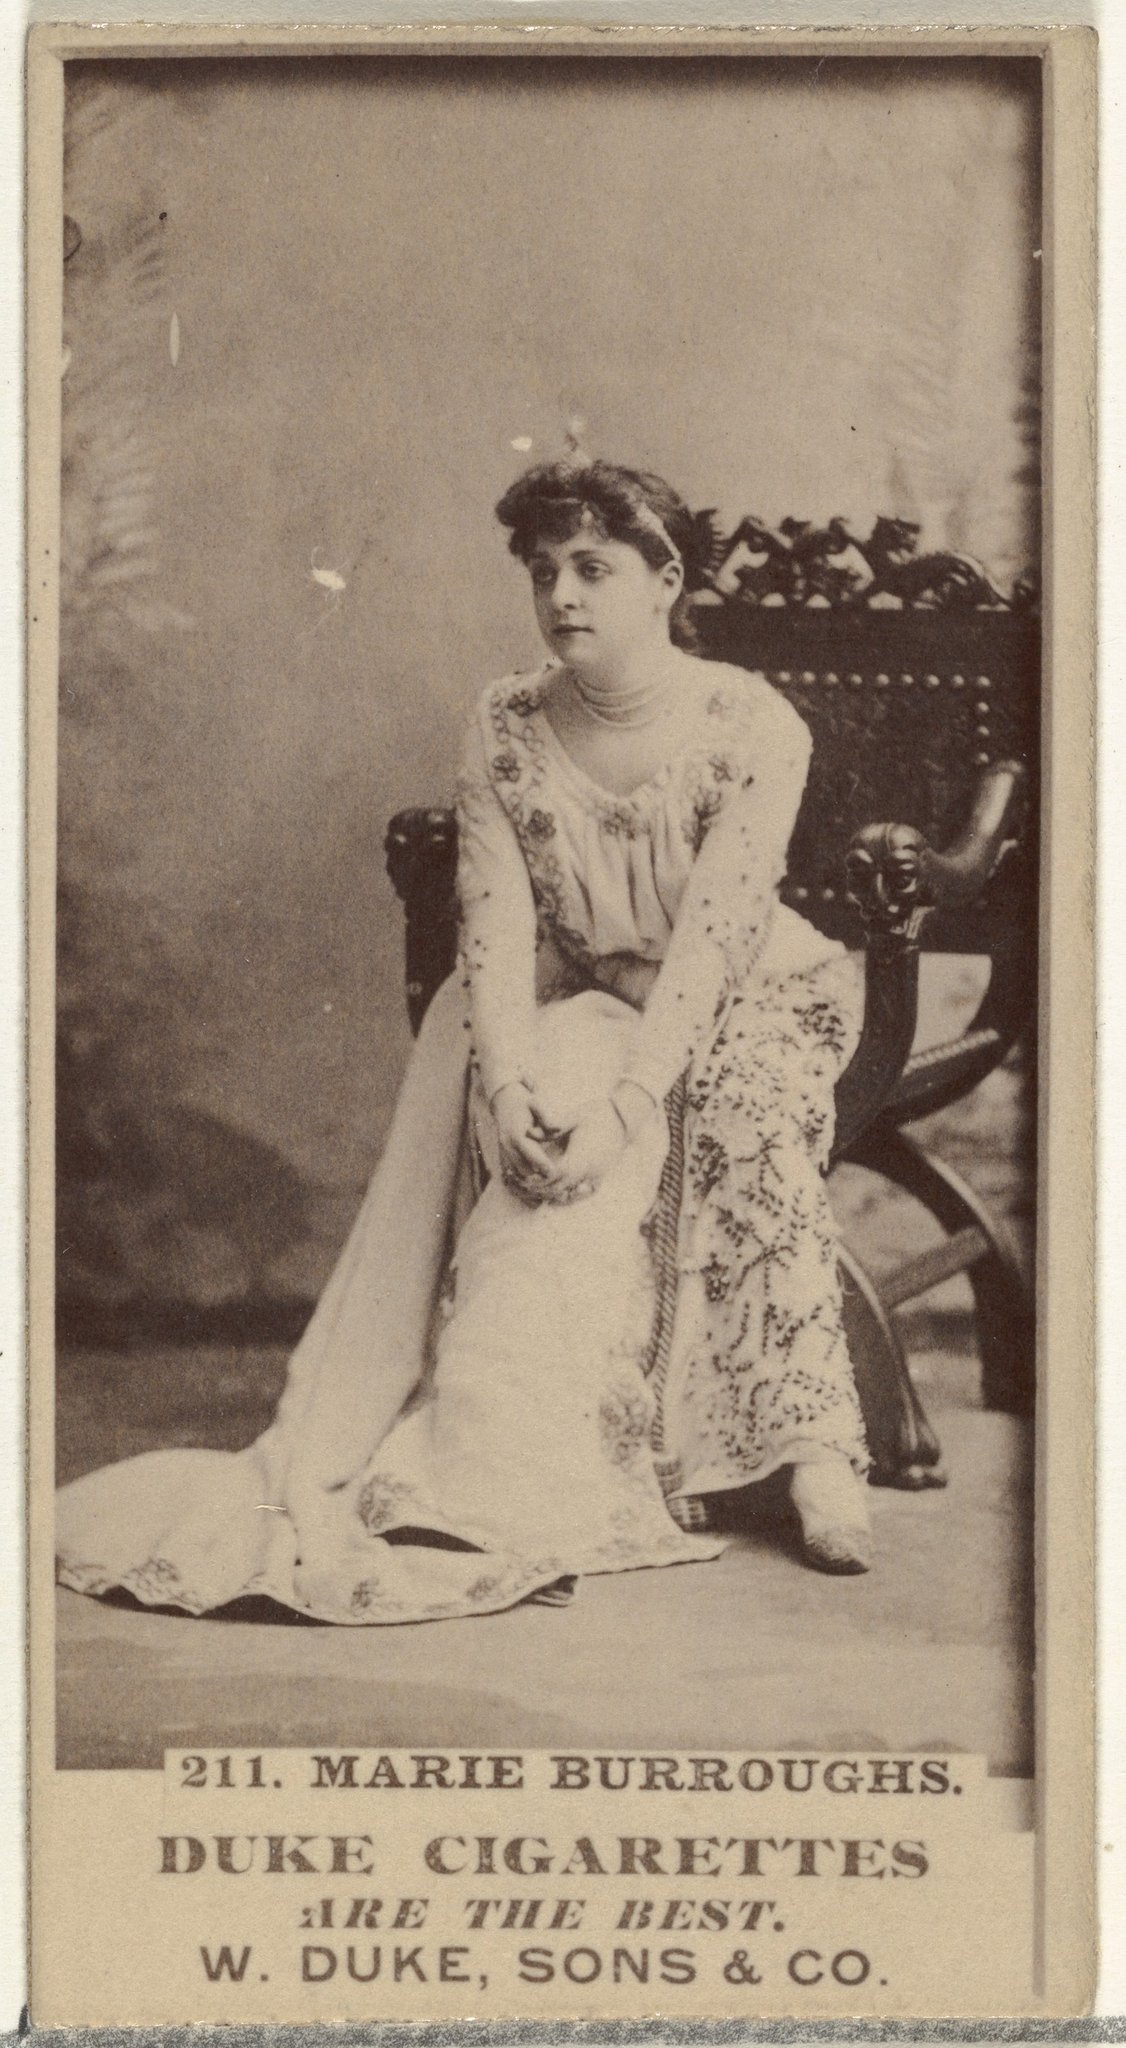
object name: photograph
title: Card Number 211, Marie Burroughs, from the Actors and Actresses series (N145-7) issued by Duke Sons & Co. to promote Duke Cigarettes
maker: w. duke, sons & co.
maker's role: publisher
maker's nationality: american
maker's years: 1870-1920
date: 1880-1889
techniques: albumen silver print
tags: portraits,women,actresses